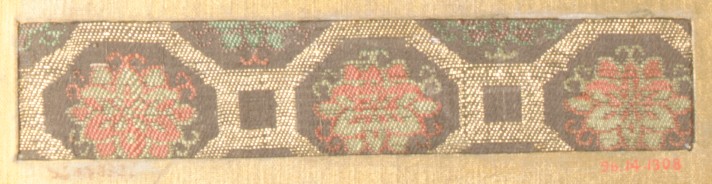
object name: piece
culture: japanese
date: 1701-1900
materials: silk